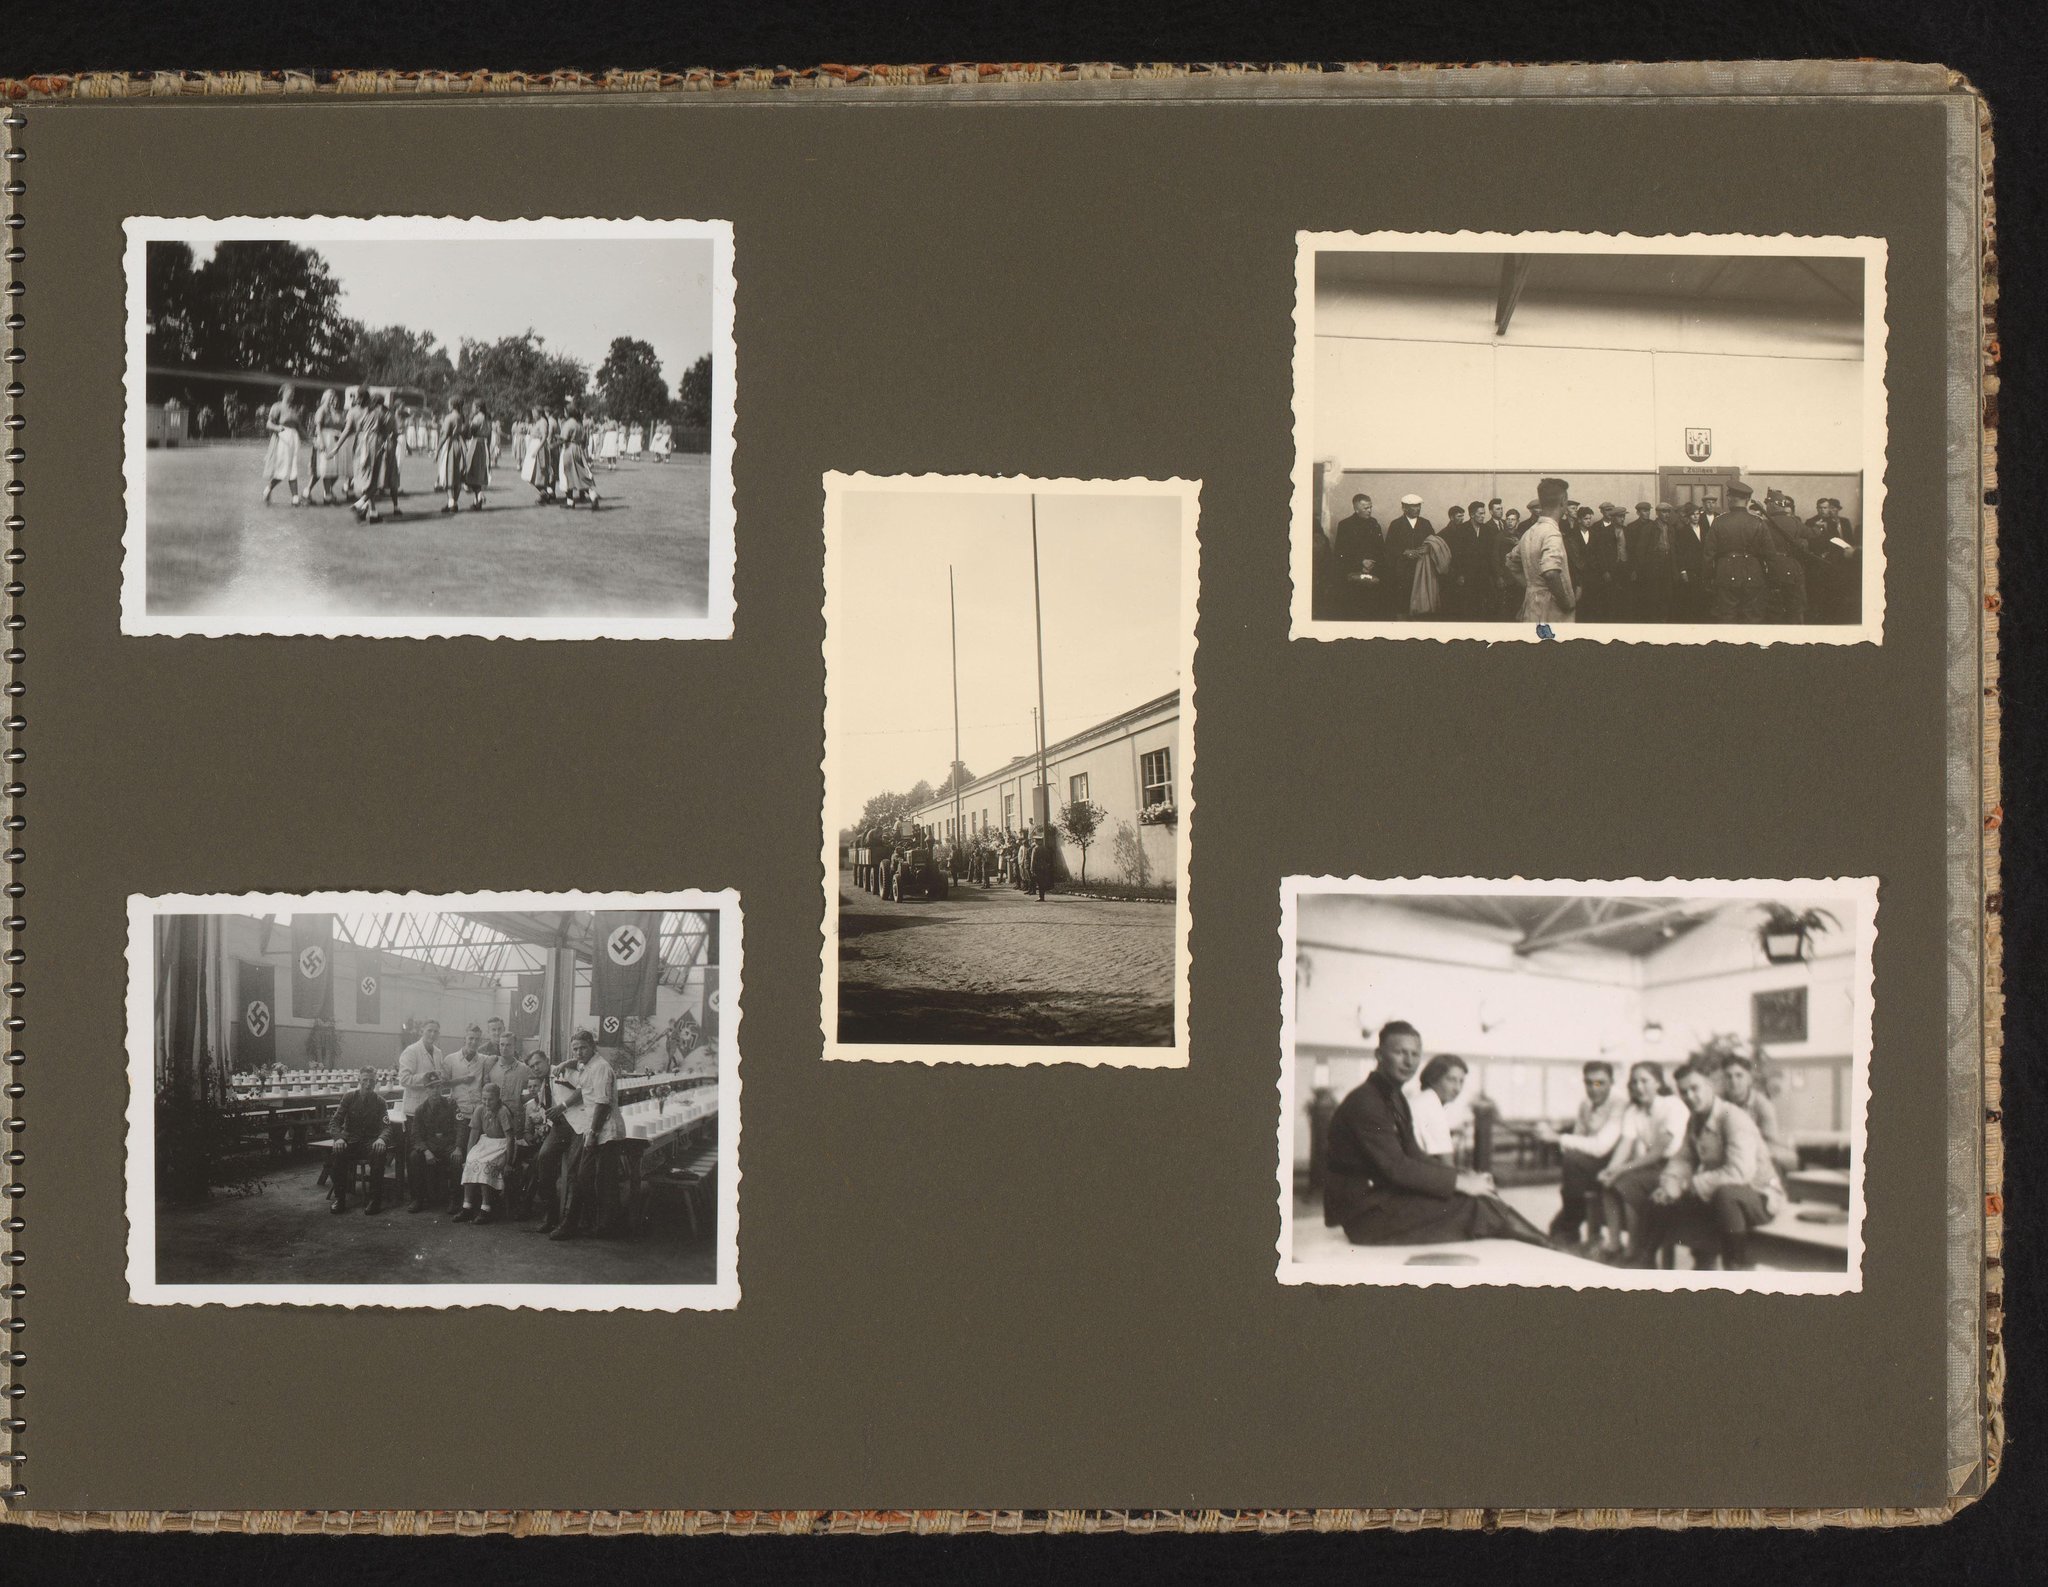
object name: album leaf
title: Soldatenleven tijdens de opleiding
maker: Anonymous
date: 1935-1940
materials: cardboard, photographic support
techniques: gelatin silver print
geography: germany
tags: military training, germany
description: Albumblad met vijf foto's van het soldatenleven tijdens de opleiding bij de Reichsarbeitsdienst: in en om de kazerne, bezoek met vrouwen, aankomst nieuwe recruten en voorbereiding voor een bijeenkomst in een grote hal versierd met vlaggen met hakenkruisen. Onderdeel van het fotoalbum Duitse bezetting van Nederland.